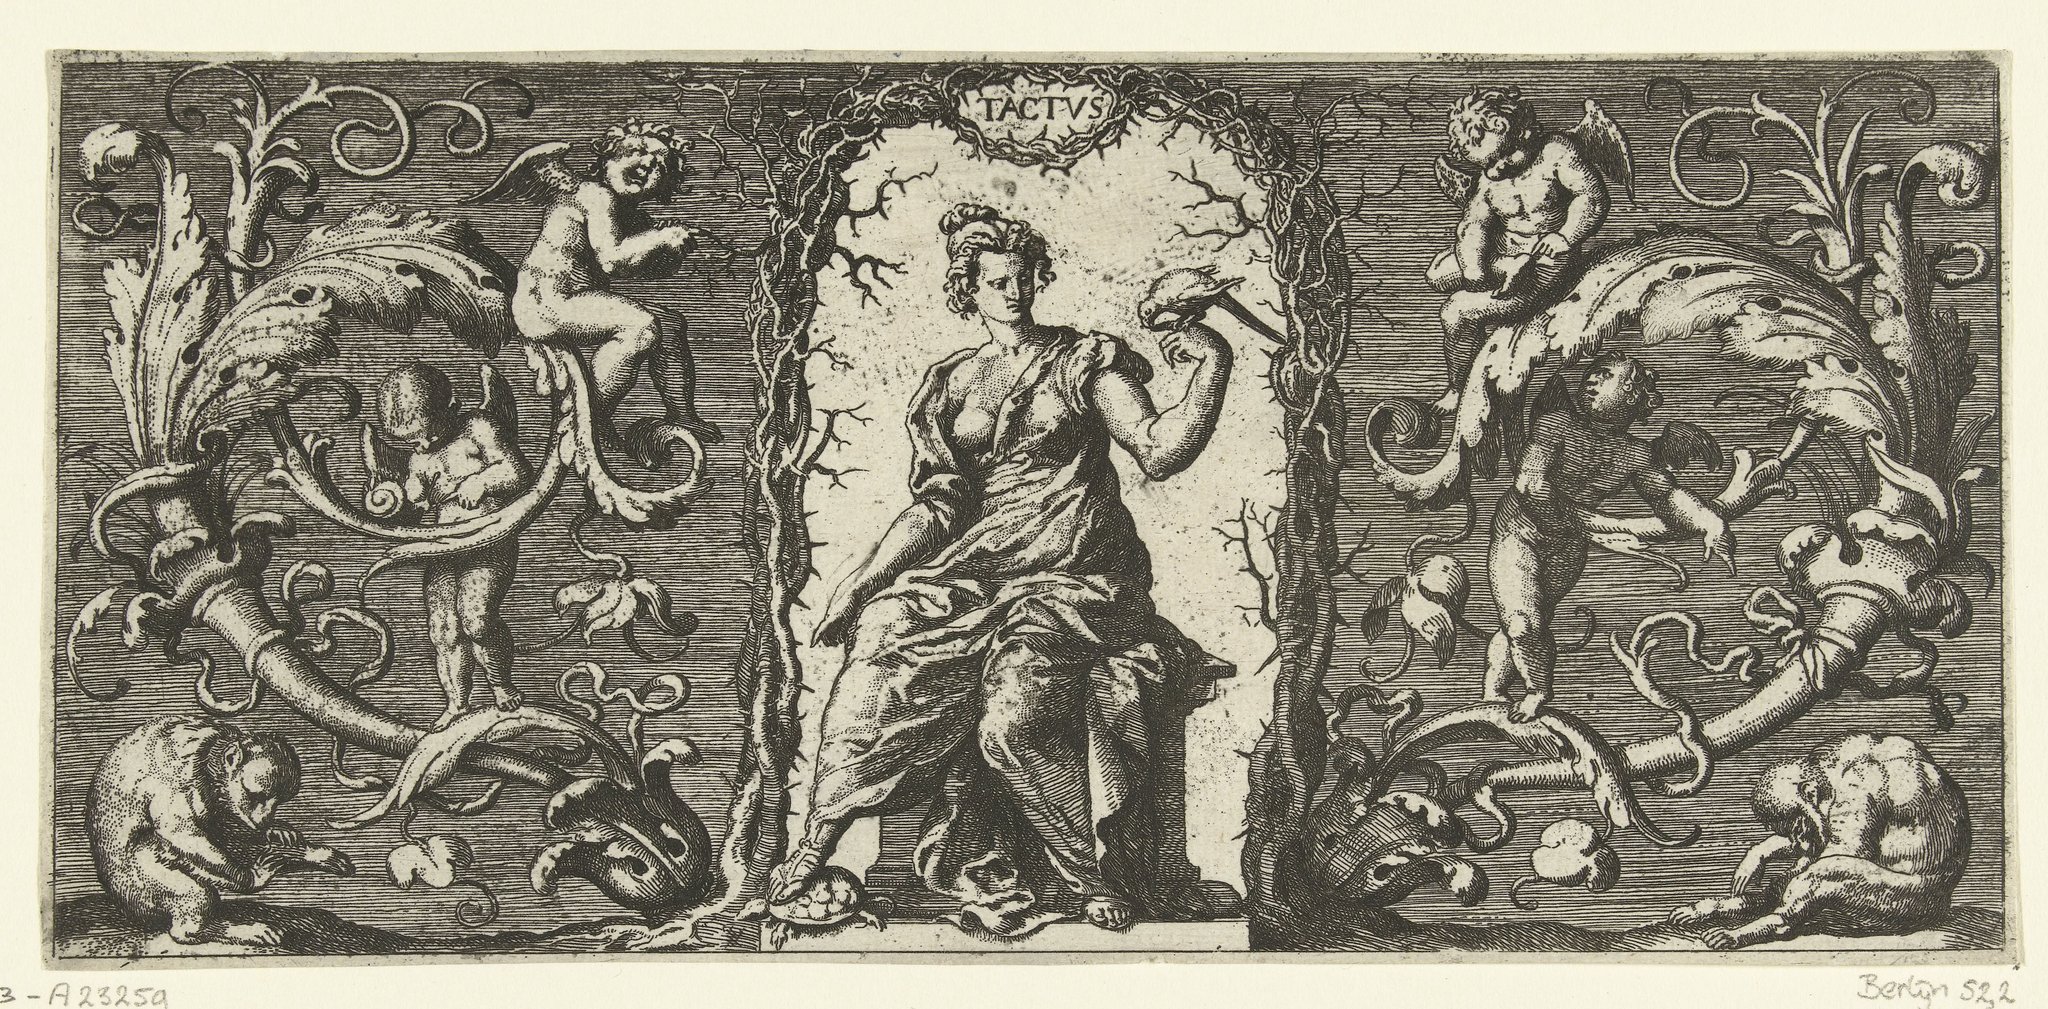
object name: ornament print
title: Quinque Sensuum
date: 1655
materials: paper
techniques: etching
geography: england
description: Een vrouw wordt in de vinger gebeten door een vogel. Blad uit serie bestaande uit een titelblad en 5 bladen met personificaties van de zintuigen, derde editie.